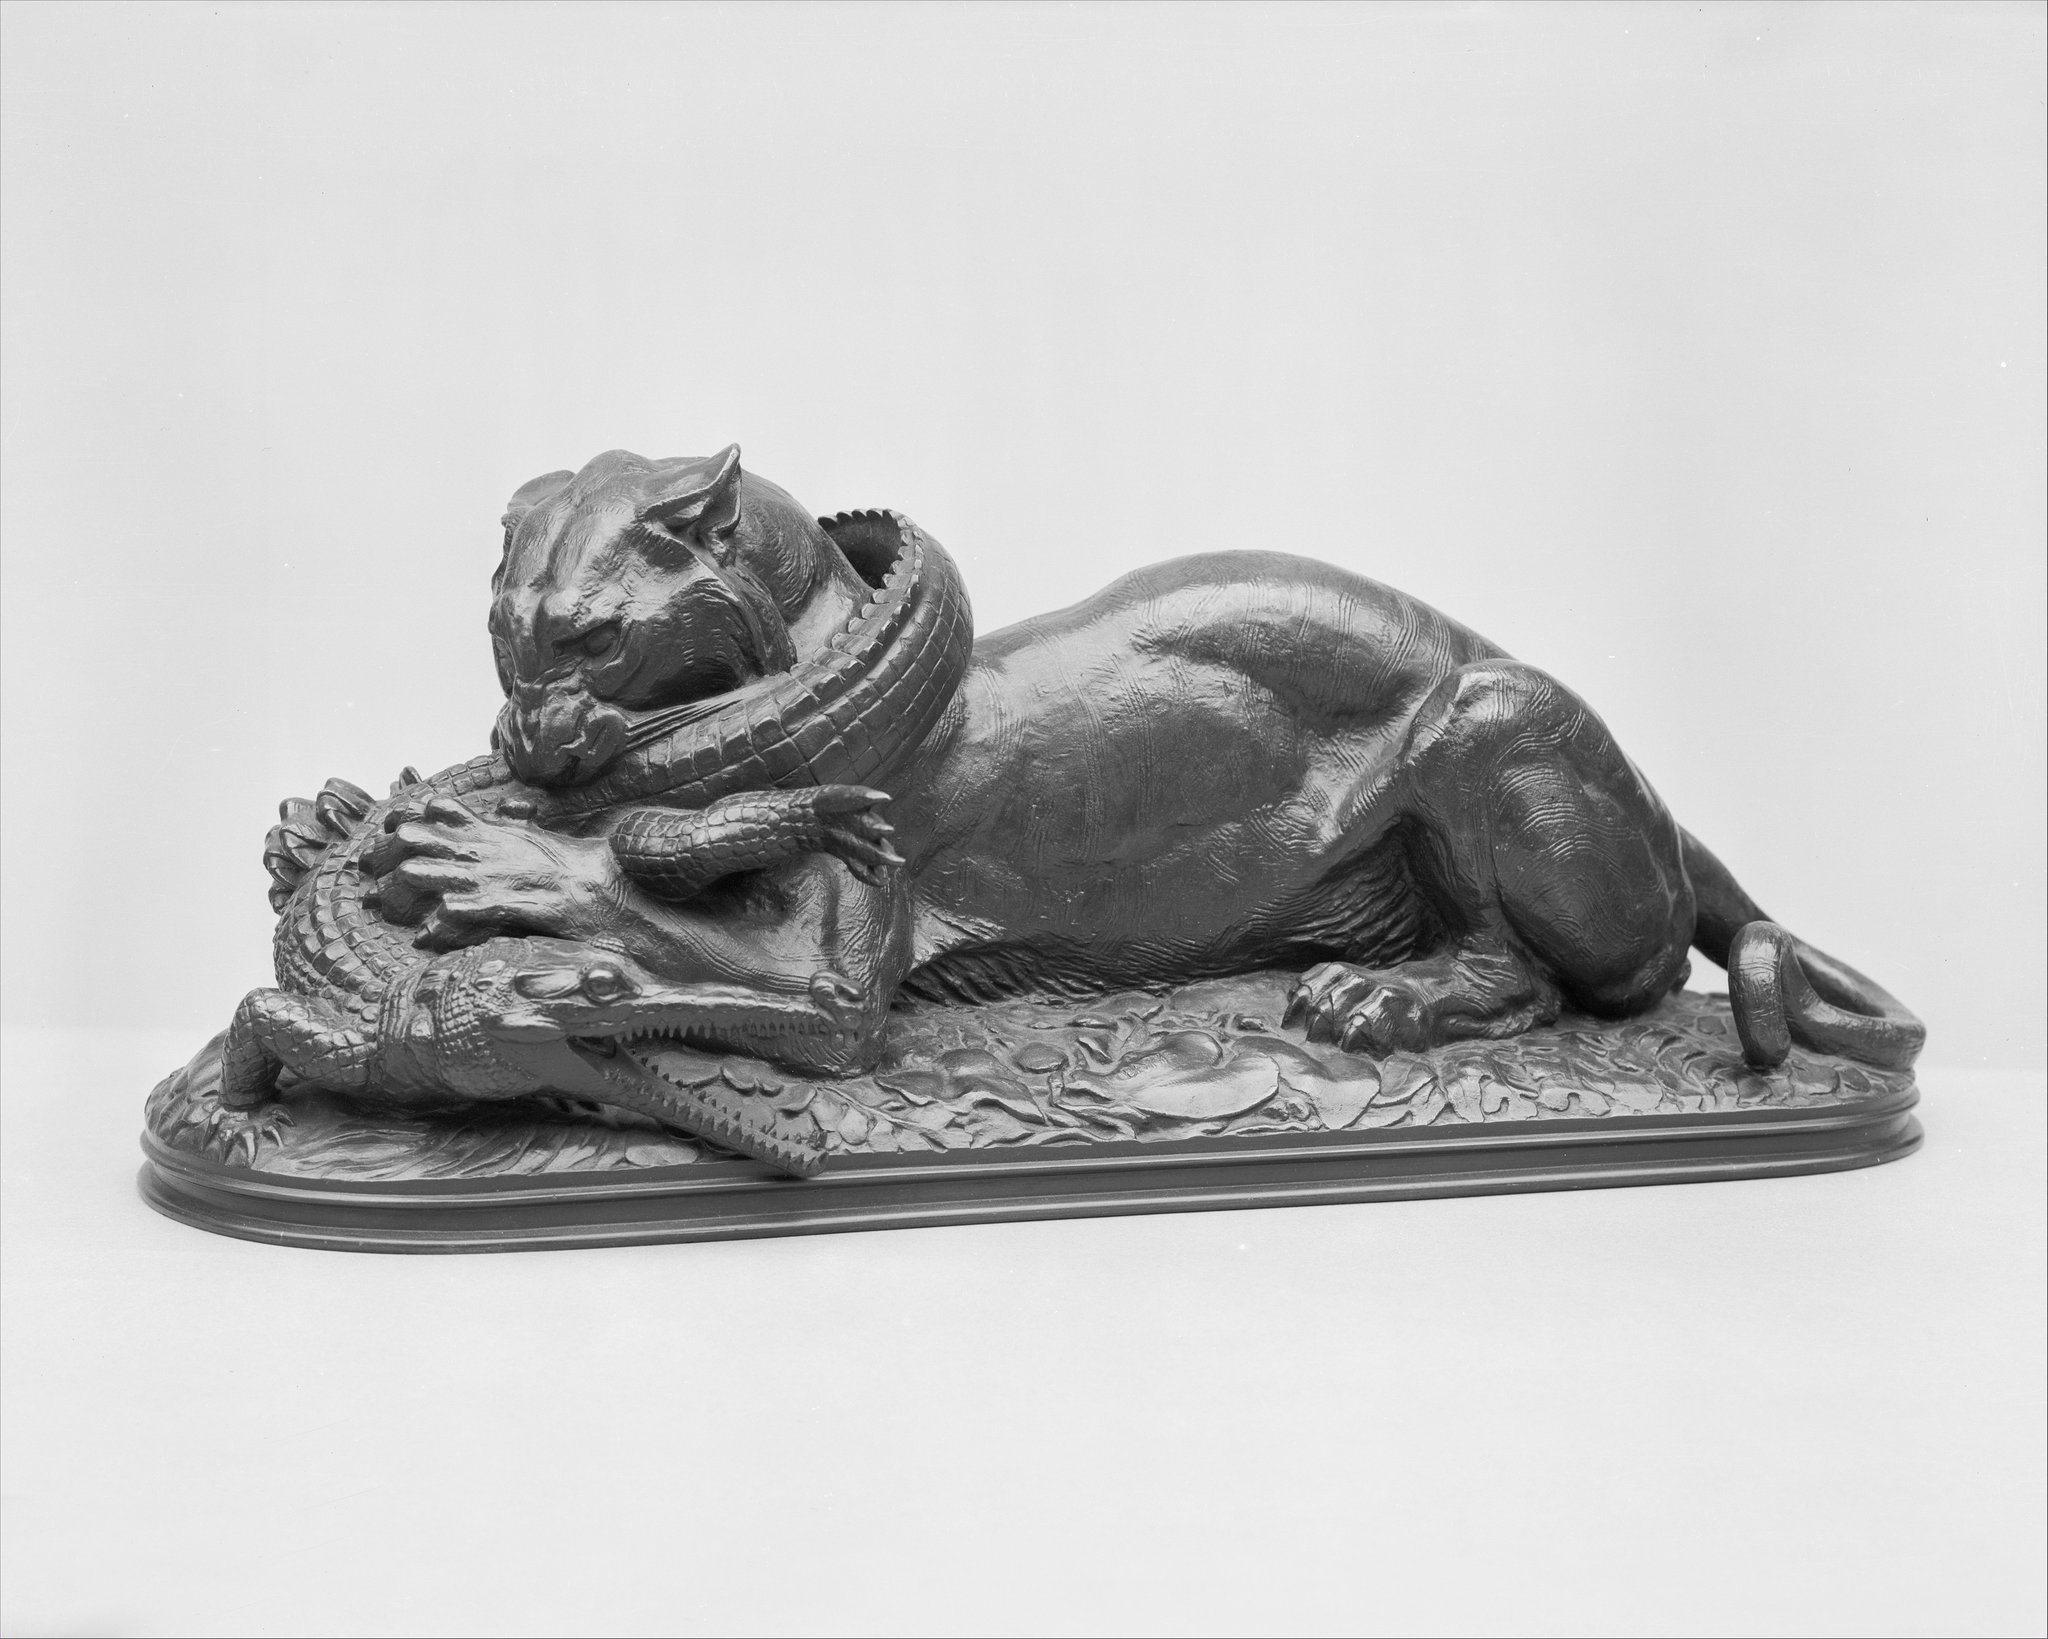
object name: statuette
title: Tiger Devouring a Gavial (Tigre dévorant un gavial)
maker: antoine-louis barye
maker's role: artist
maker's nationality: french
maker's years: 1795-1875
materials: bronze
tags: crocodiles,tigers